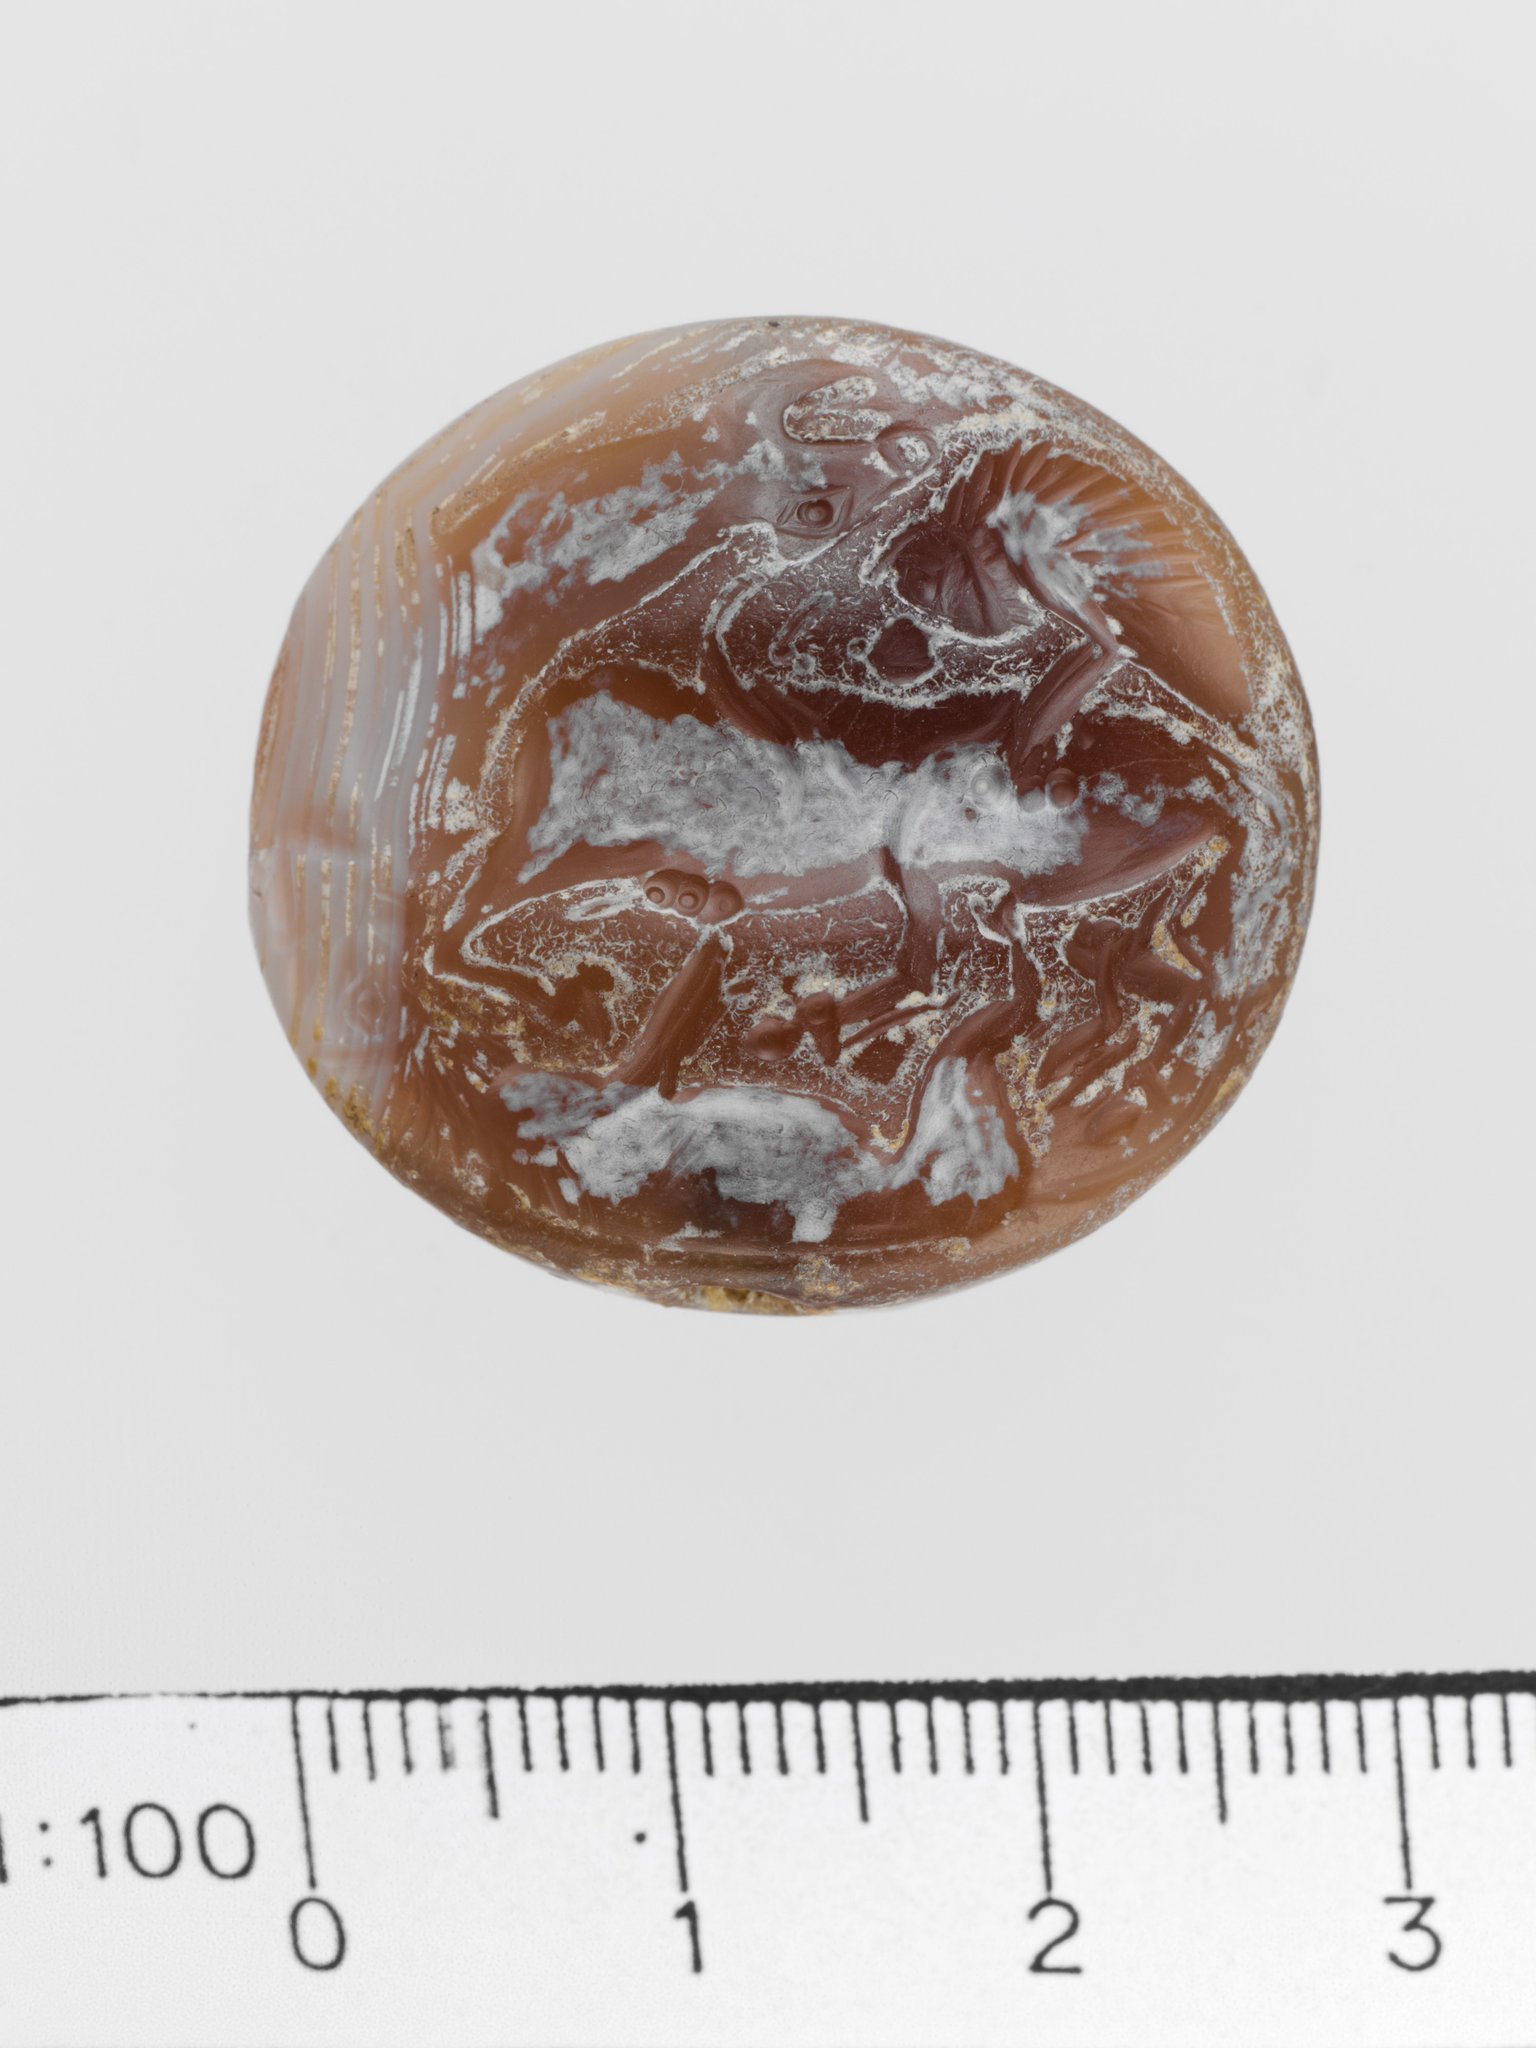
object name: seal, lentoid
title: Agate lentoid seal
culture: minoan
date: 1450-1400 BCE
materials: stone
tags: bulls,lions